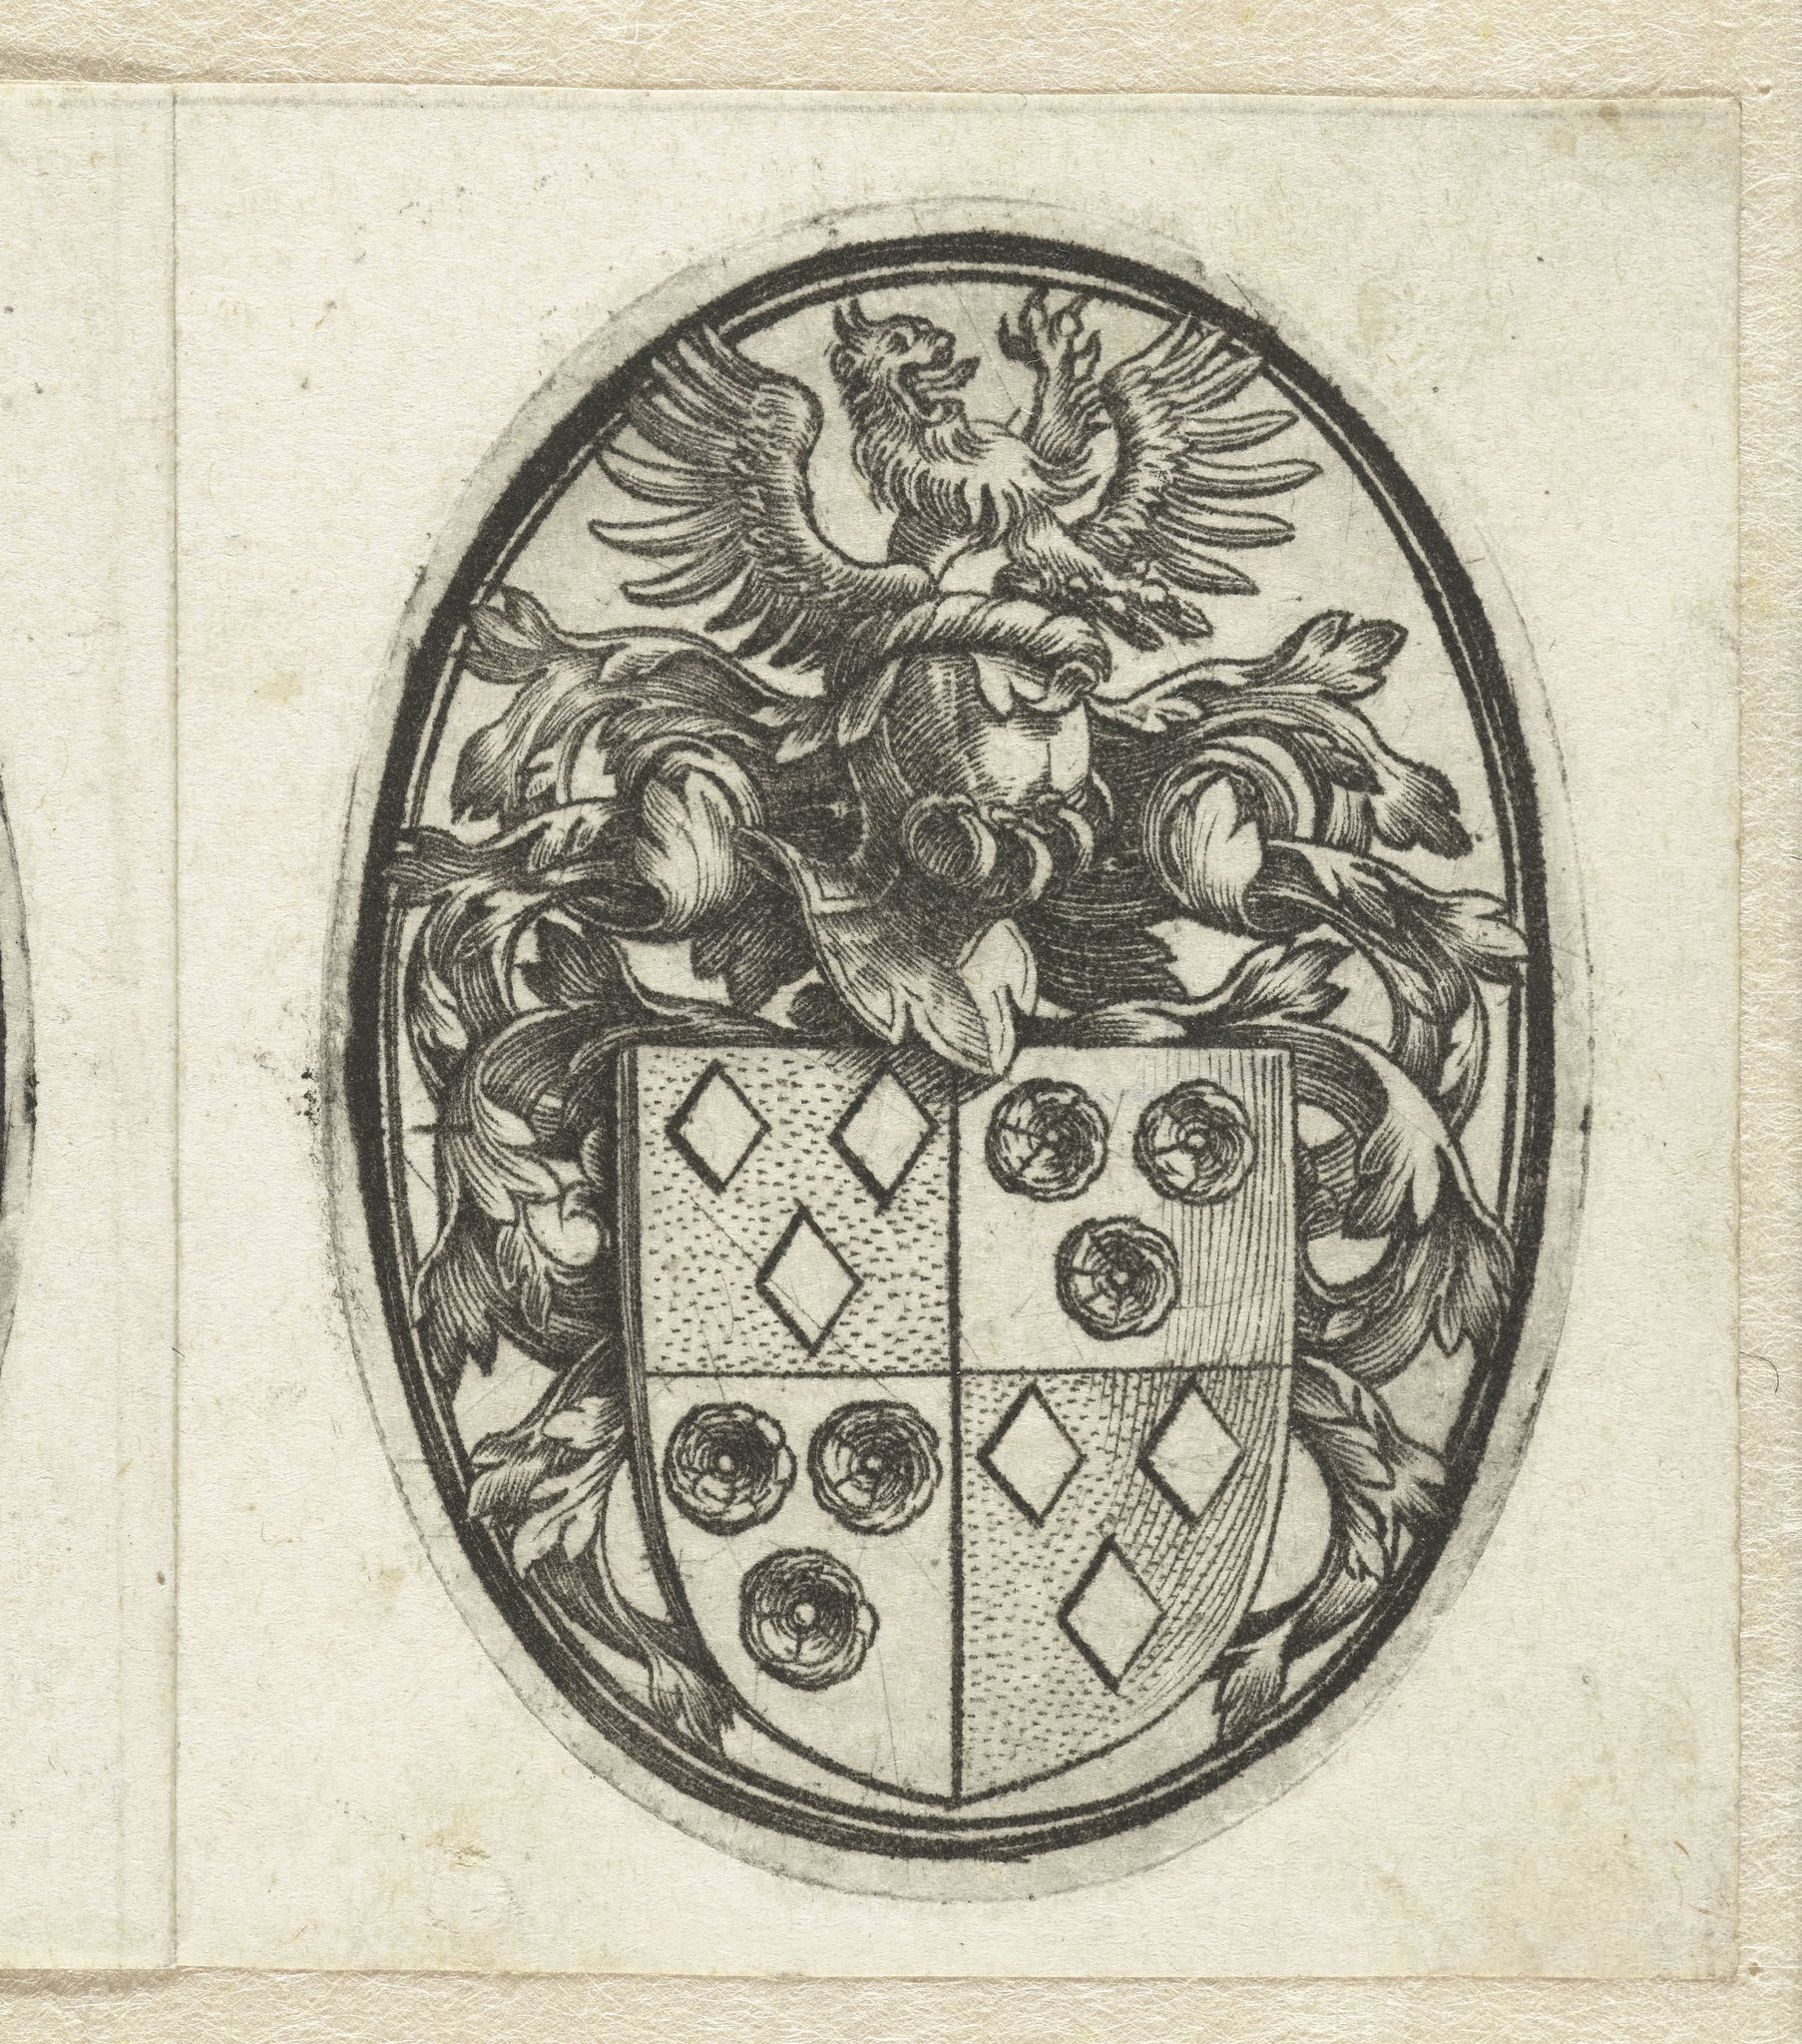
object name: print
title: Wapen van de familie Van Heussen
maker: hendrick goltzius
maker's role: draughtsman, painter, print maker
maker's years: 1558-1617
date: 1579-1584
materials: paper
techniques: engraving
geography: haarlem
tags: armorial bearing, heraldry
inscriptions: collector's mark: Lugt 2228a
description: Familiewapen van de familie Van Heussen uit Haarlem (tweemaal drie ruiten en tweemaal drie rozetten) in ovaal. Behoort bij een portret van Jan van Heussen.